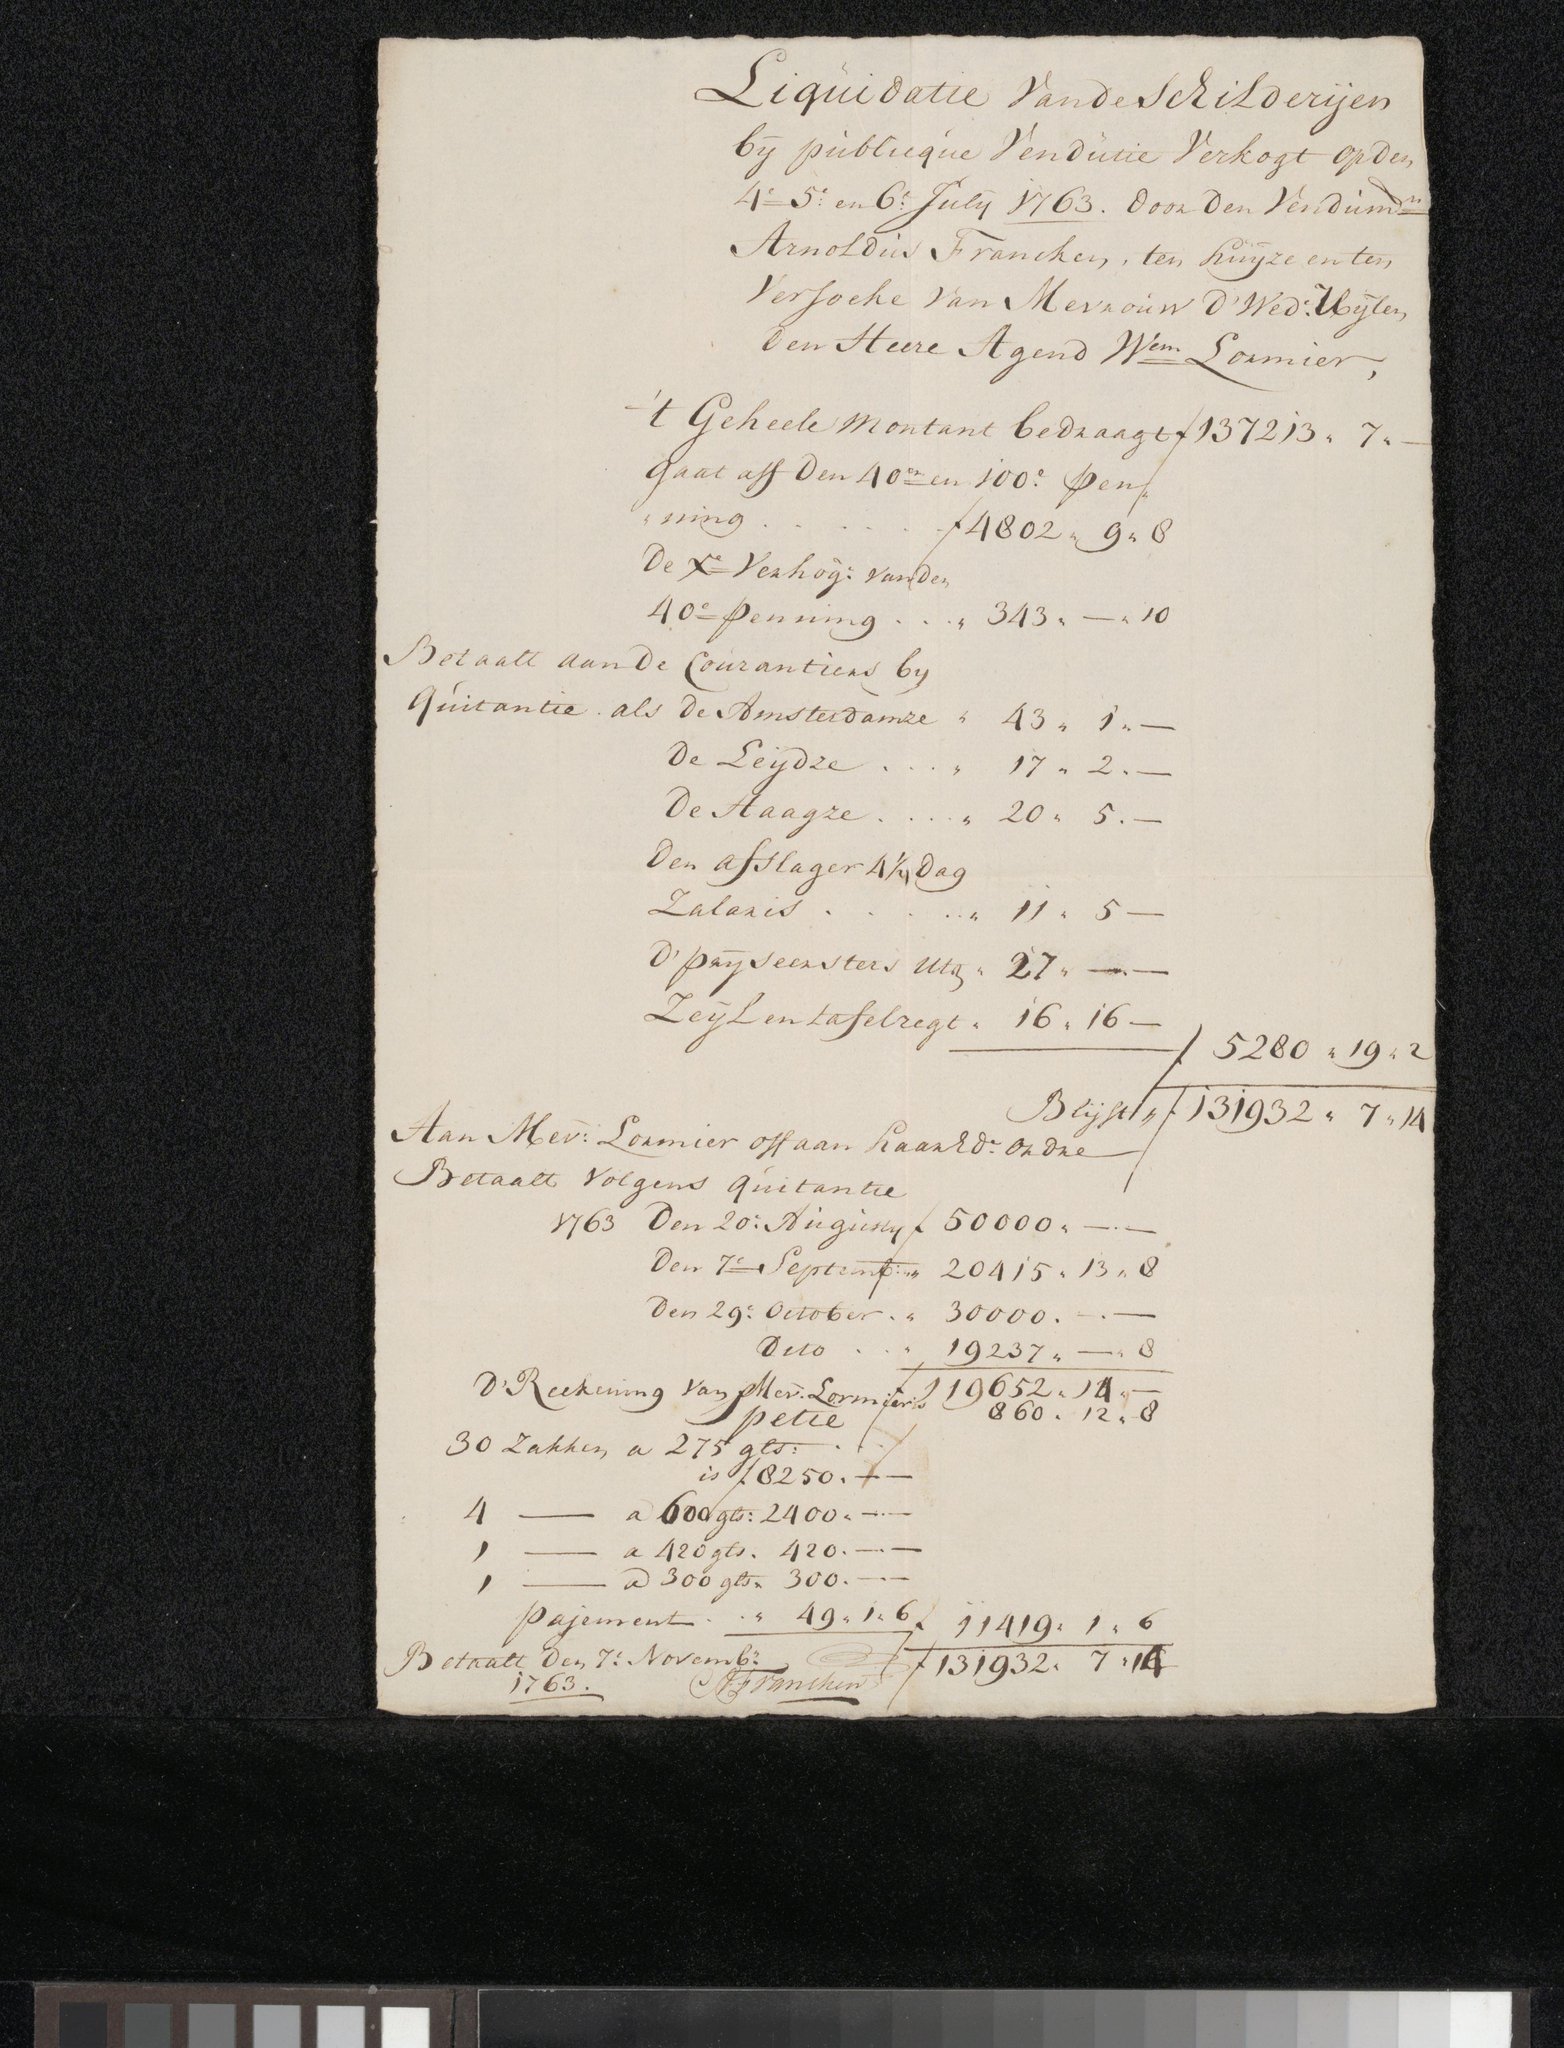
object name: aantekening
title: Aantekening betreffende de schilderijenverzameling van Willem Lormier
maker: a. francken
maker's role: veilinghuis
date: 1763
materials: ink, paper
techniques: pen, writing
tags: willem lormier, art trade, art shop, painting (including book-illumination, miniature-painting), art collecting, money